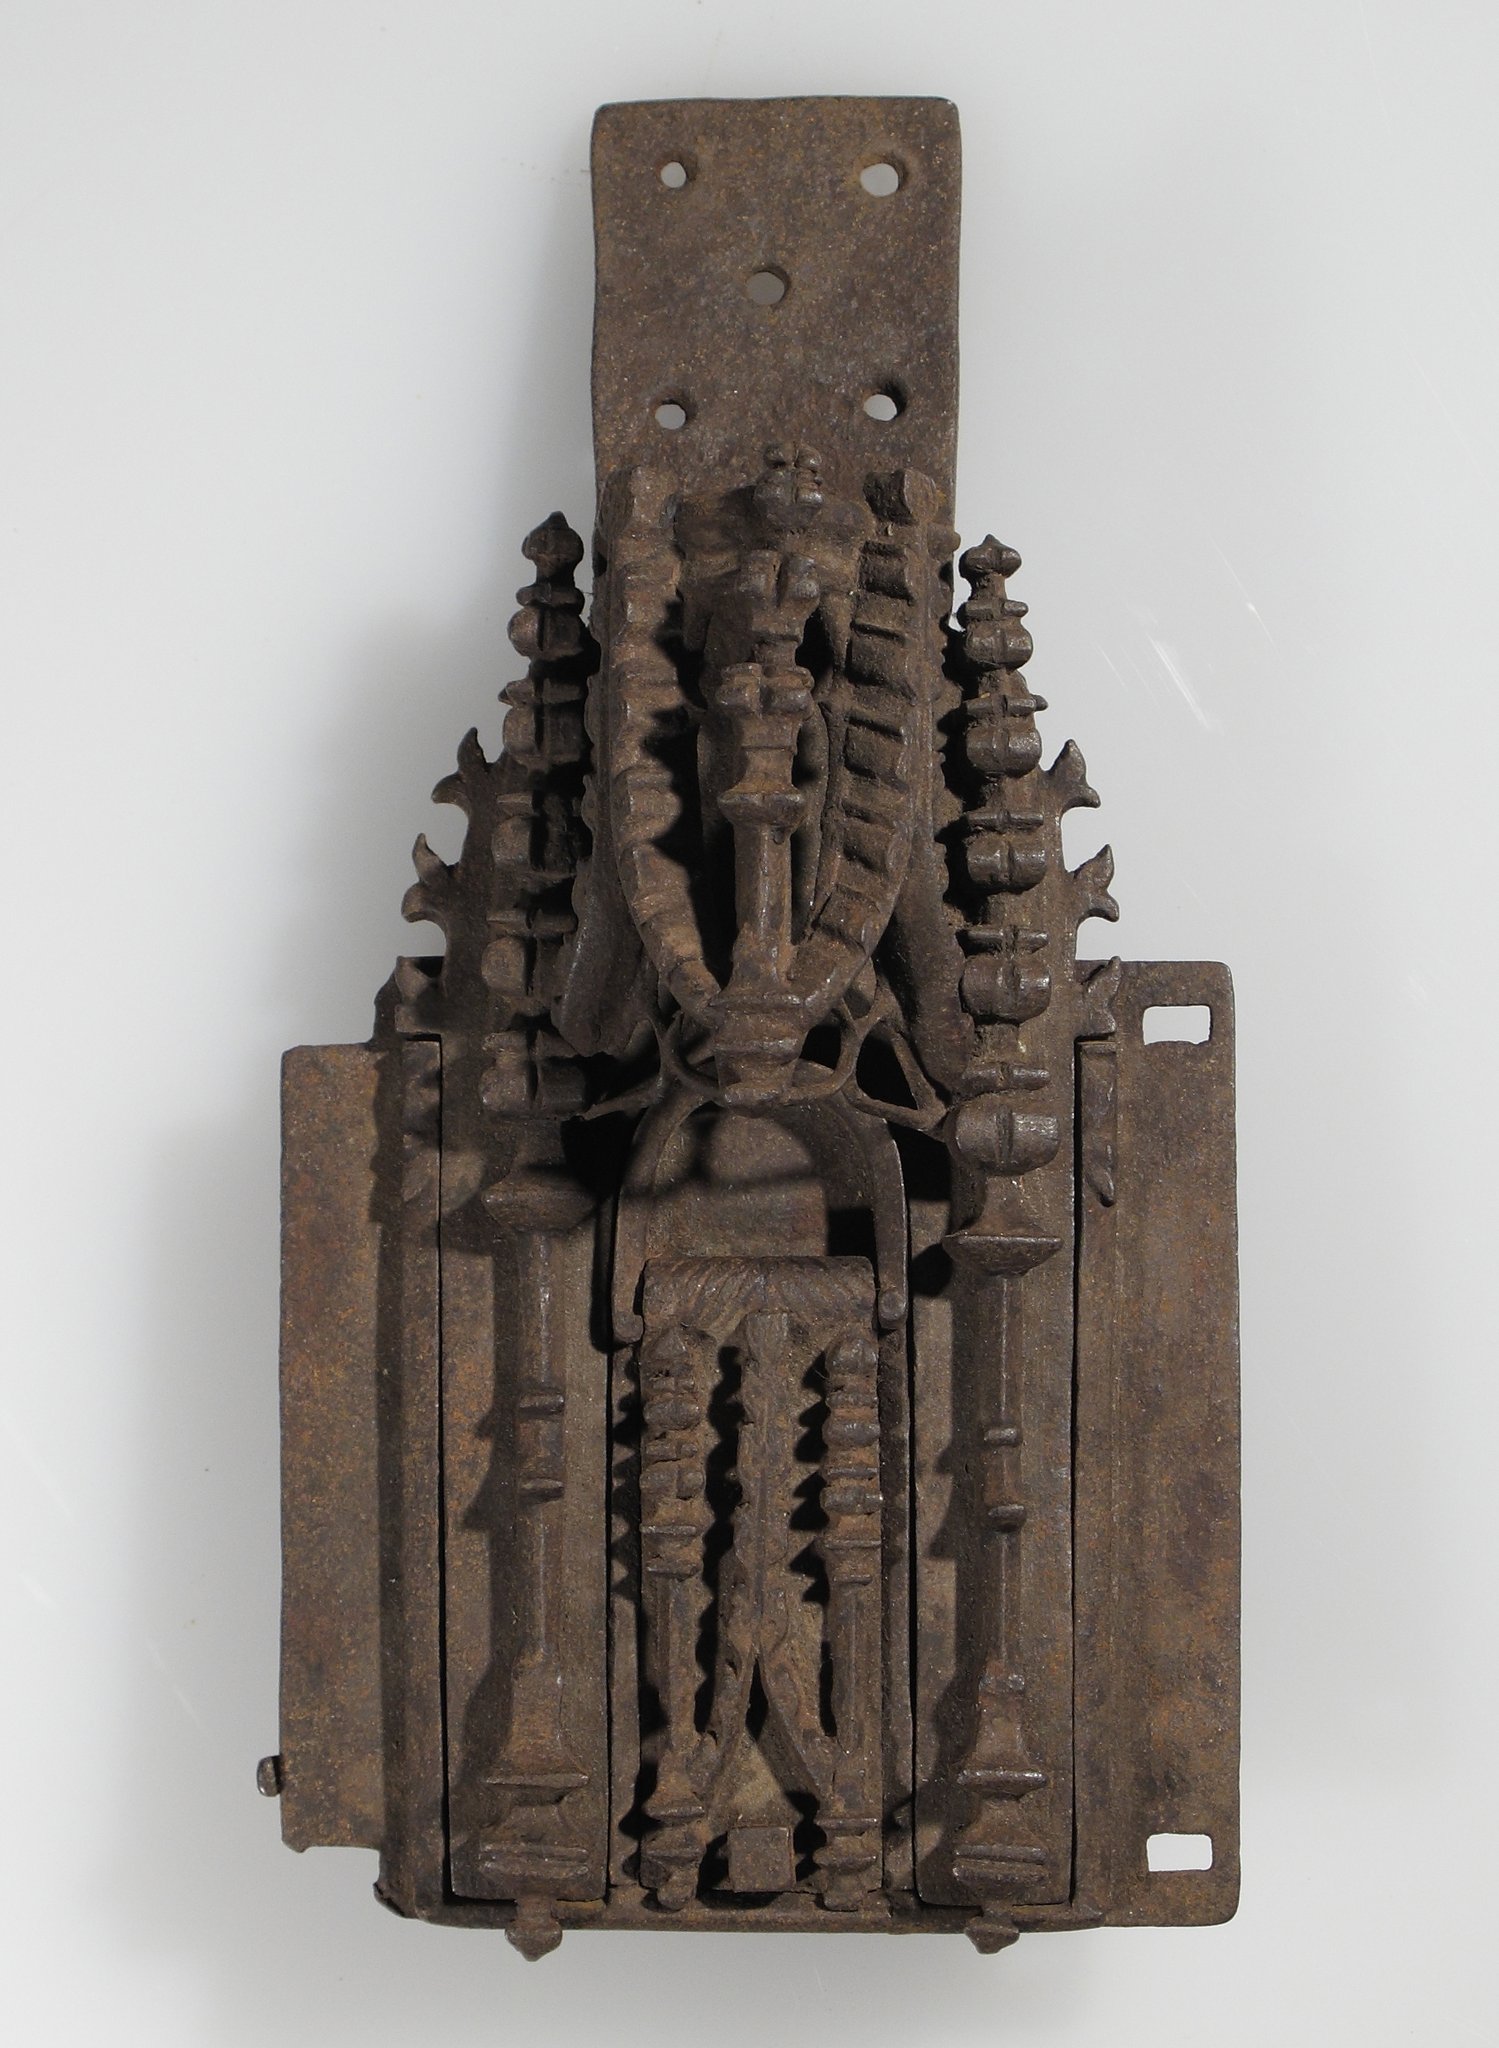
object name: lock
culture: european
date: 1401-1600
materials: iron